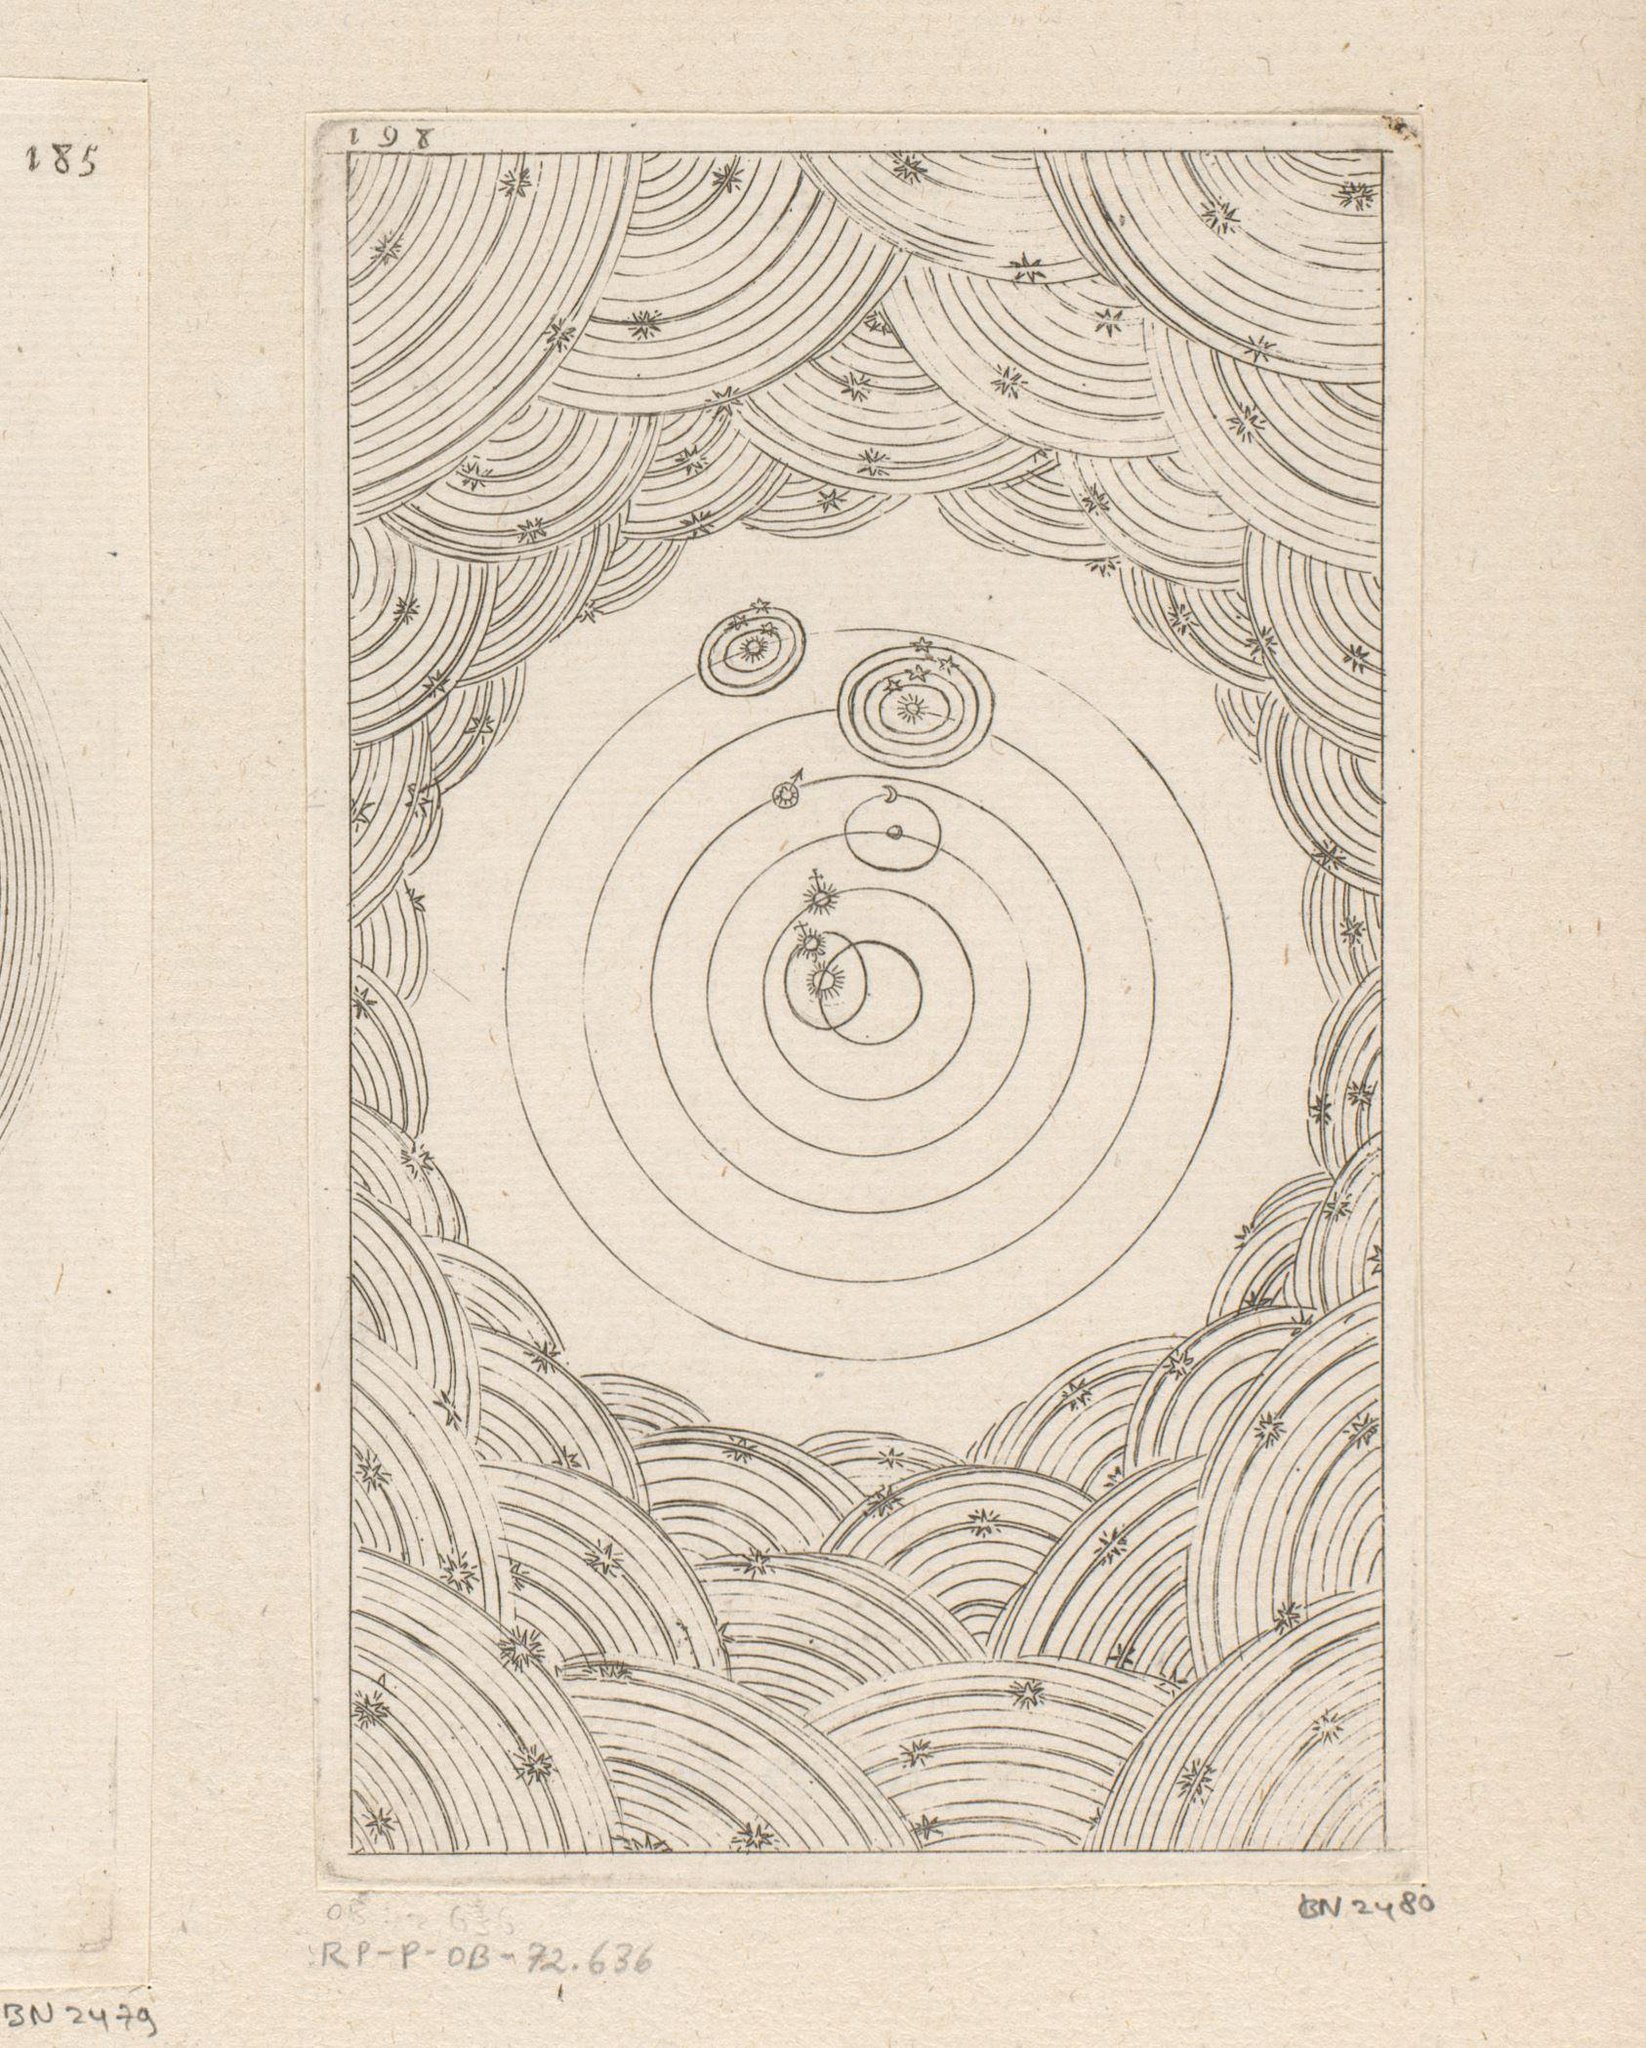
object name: print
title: Zonnestelsel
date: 1706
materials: paper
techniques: etching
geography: france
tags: planets; planetary system, solar system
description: Prent uit: Leclerc, Sébastien. Nouveau systeme du monde conforme à l'Ecriture sainte. Où les phénomènes sont expliquez sans excentricité de mouvement (...). Paris: Pierre Giffart, 1706.